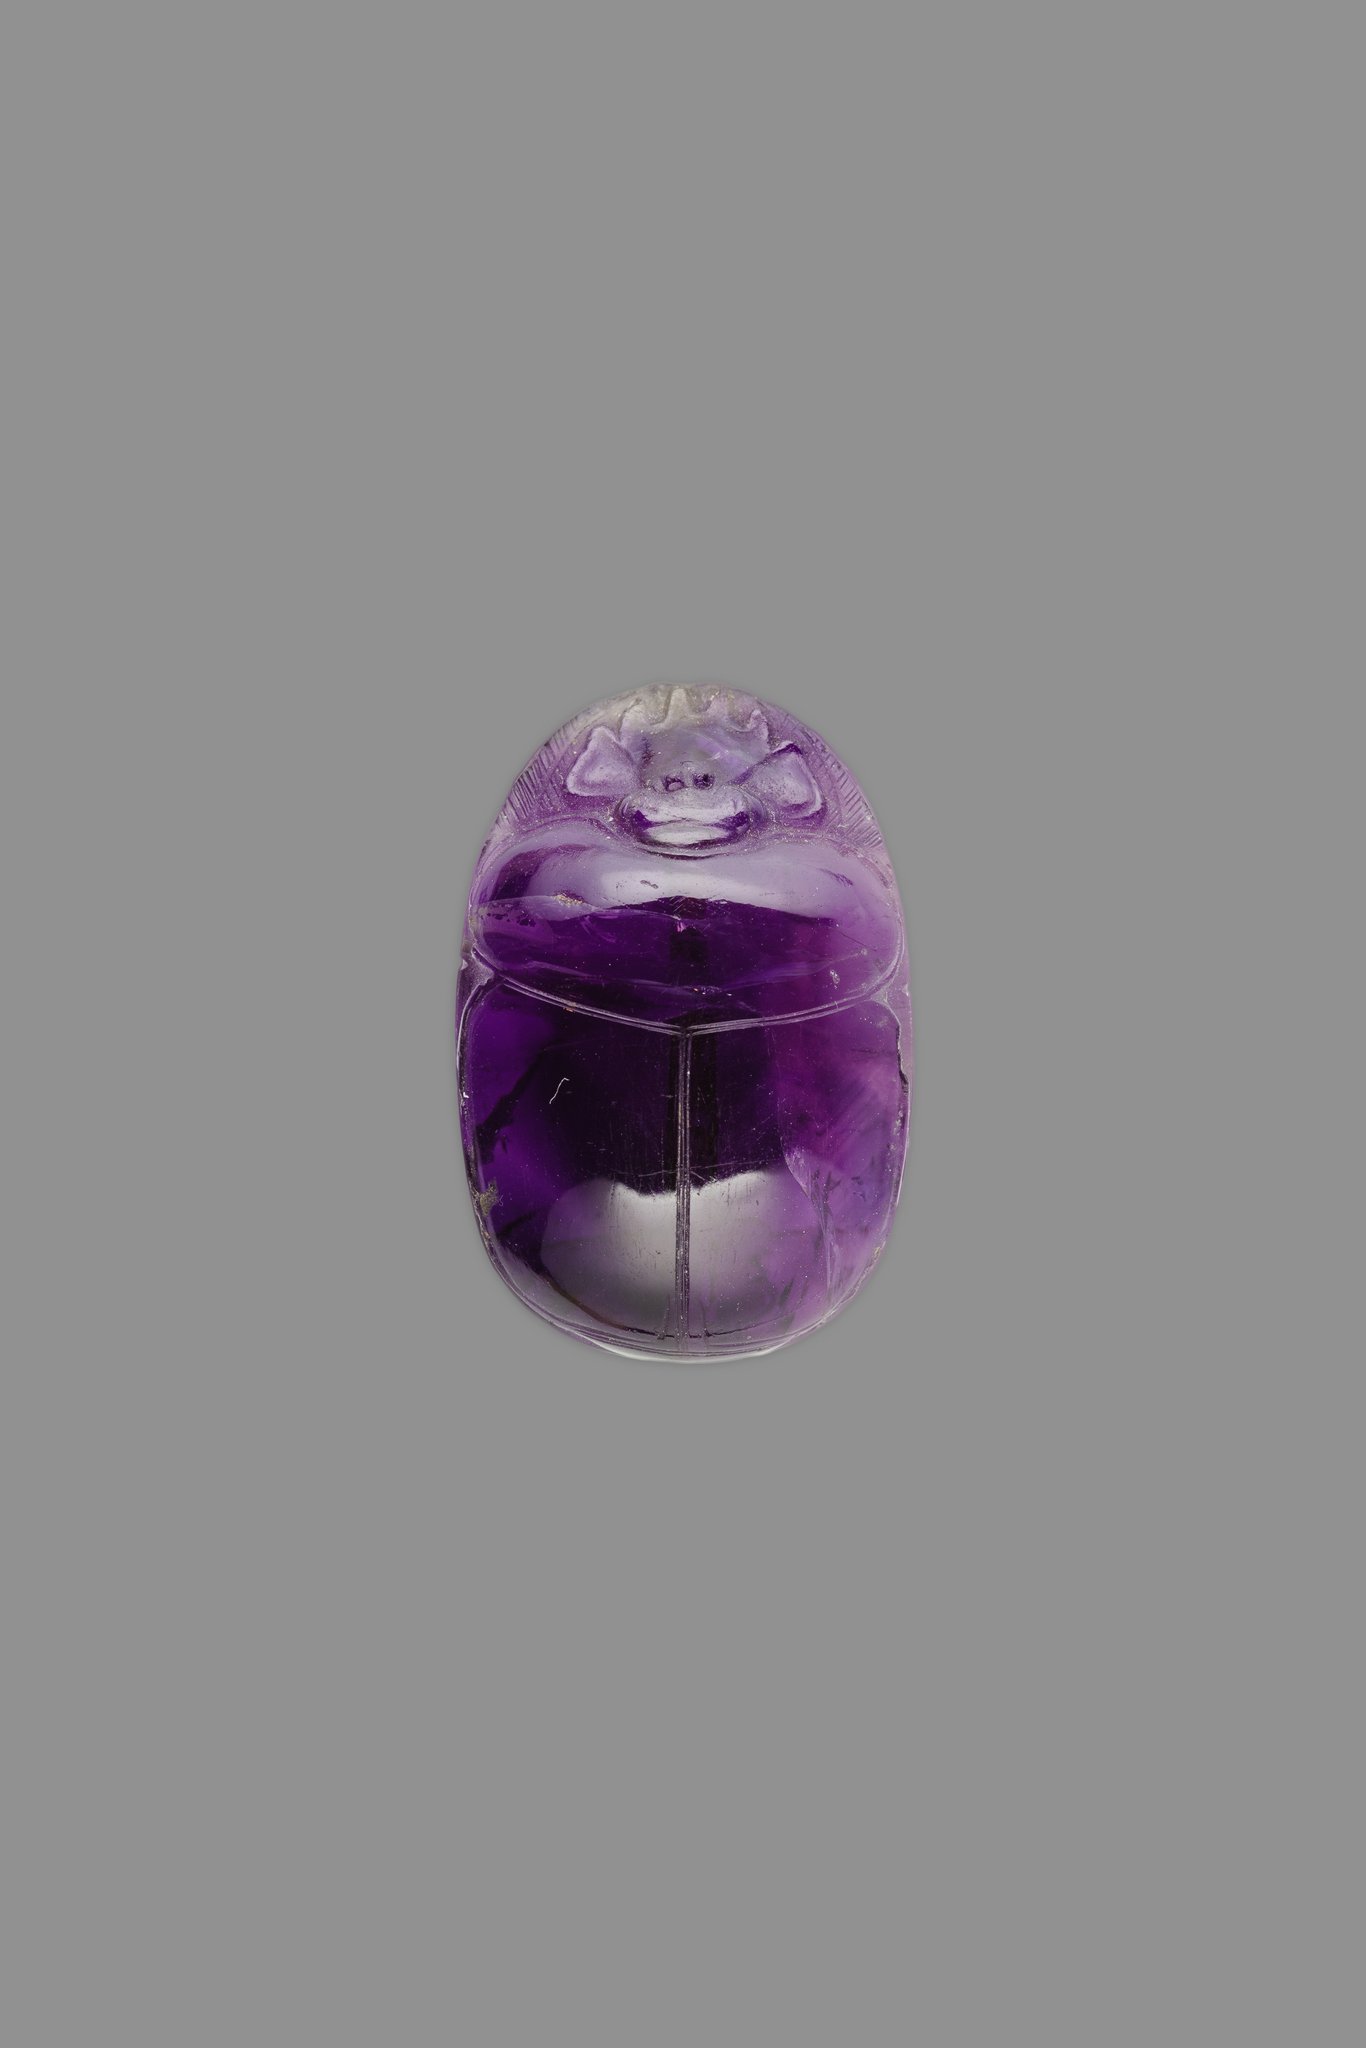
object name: scarab, uninscribed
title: Scarab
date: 1981-1950 BCE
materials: gemstone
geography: egypt